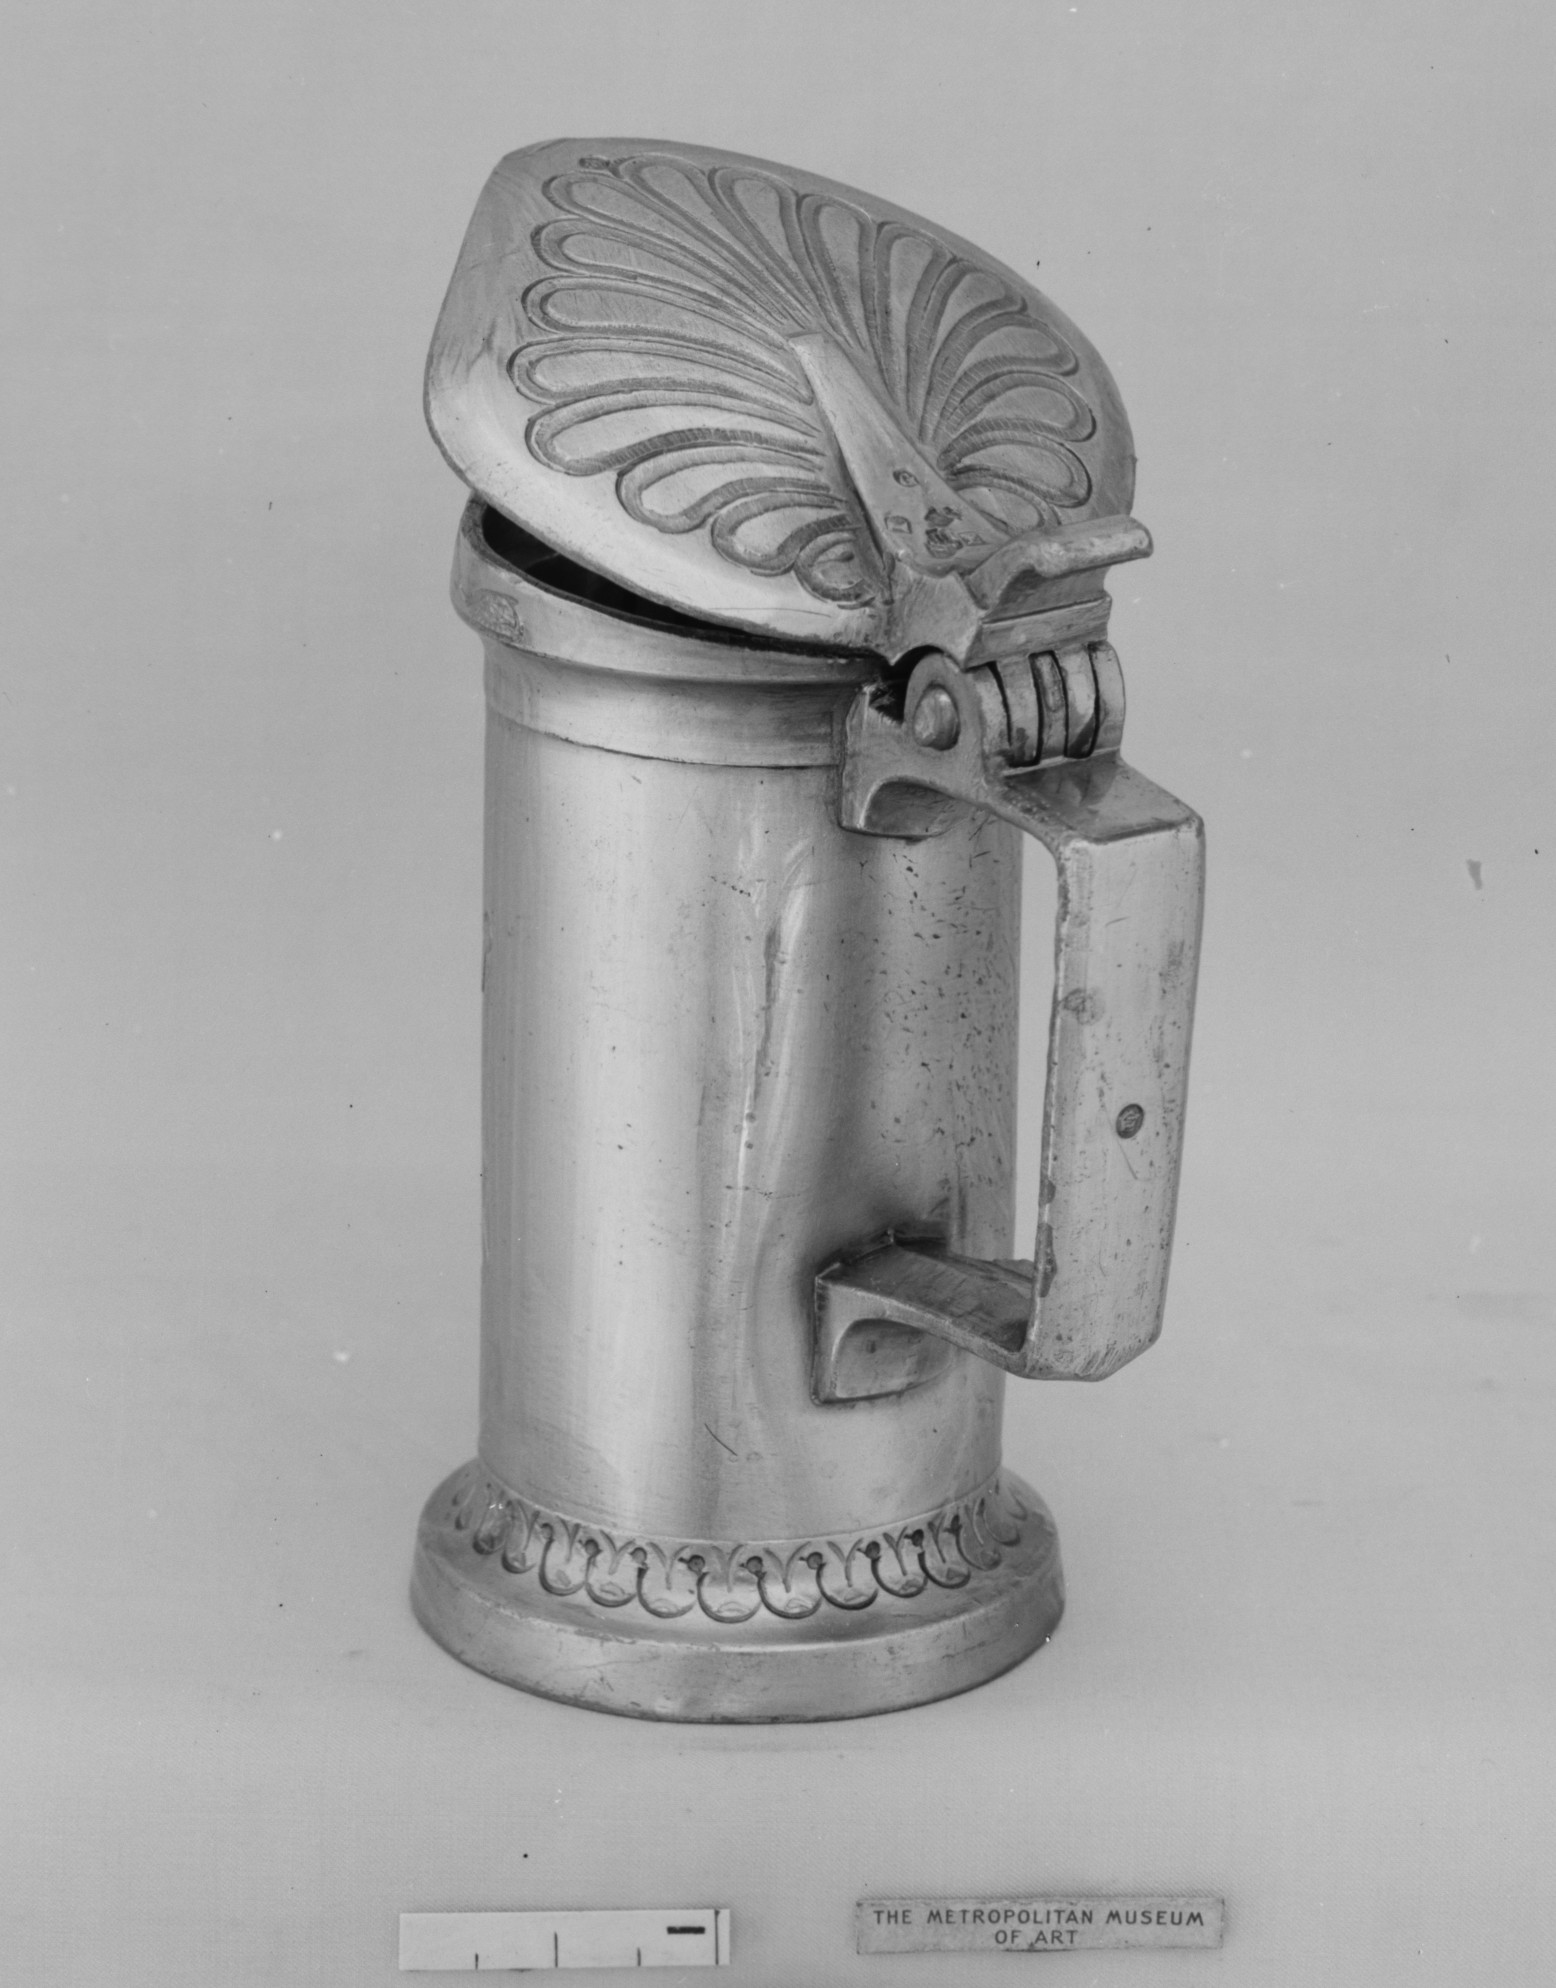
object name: spirit measure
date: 1701-1800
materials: pewter